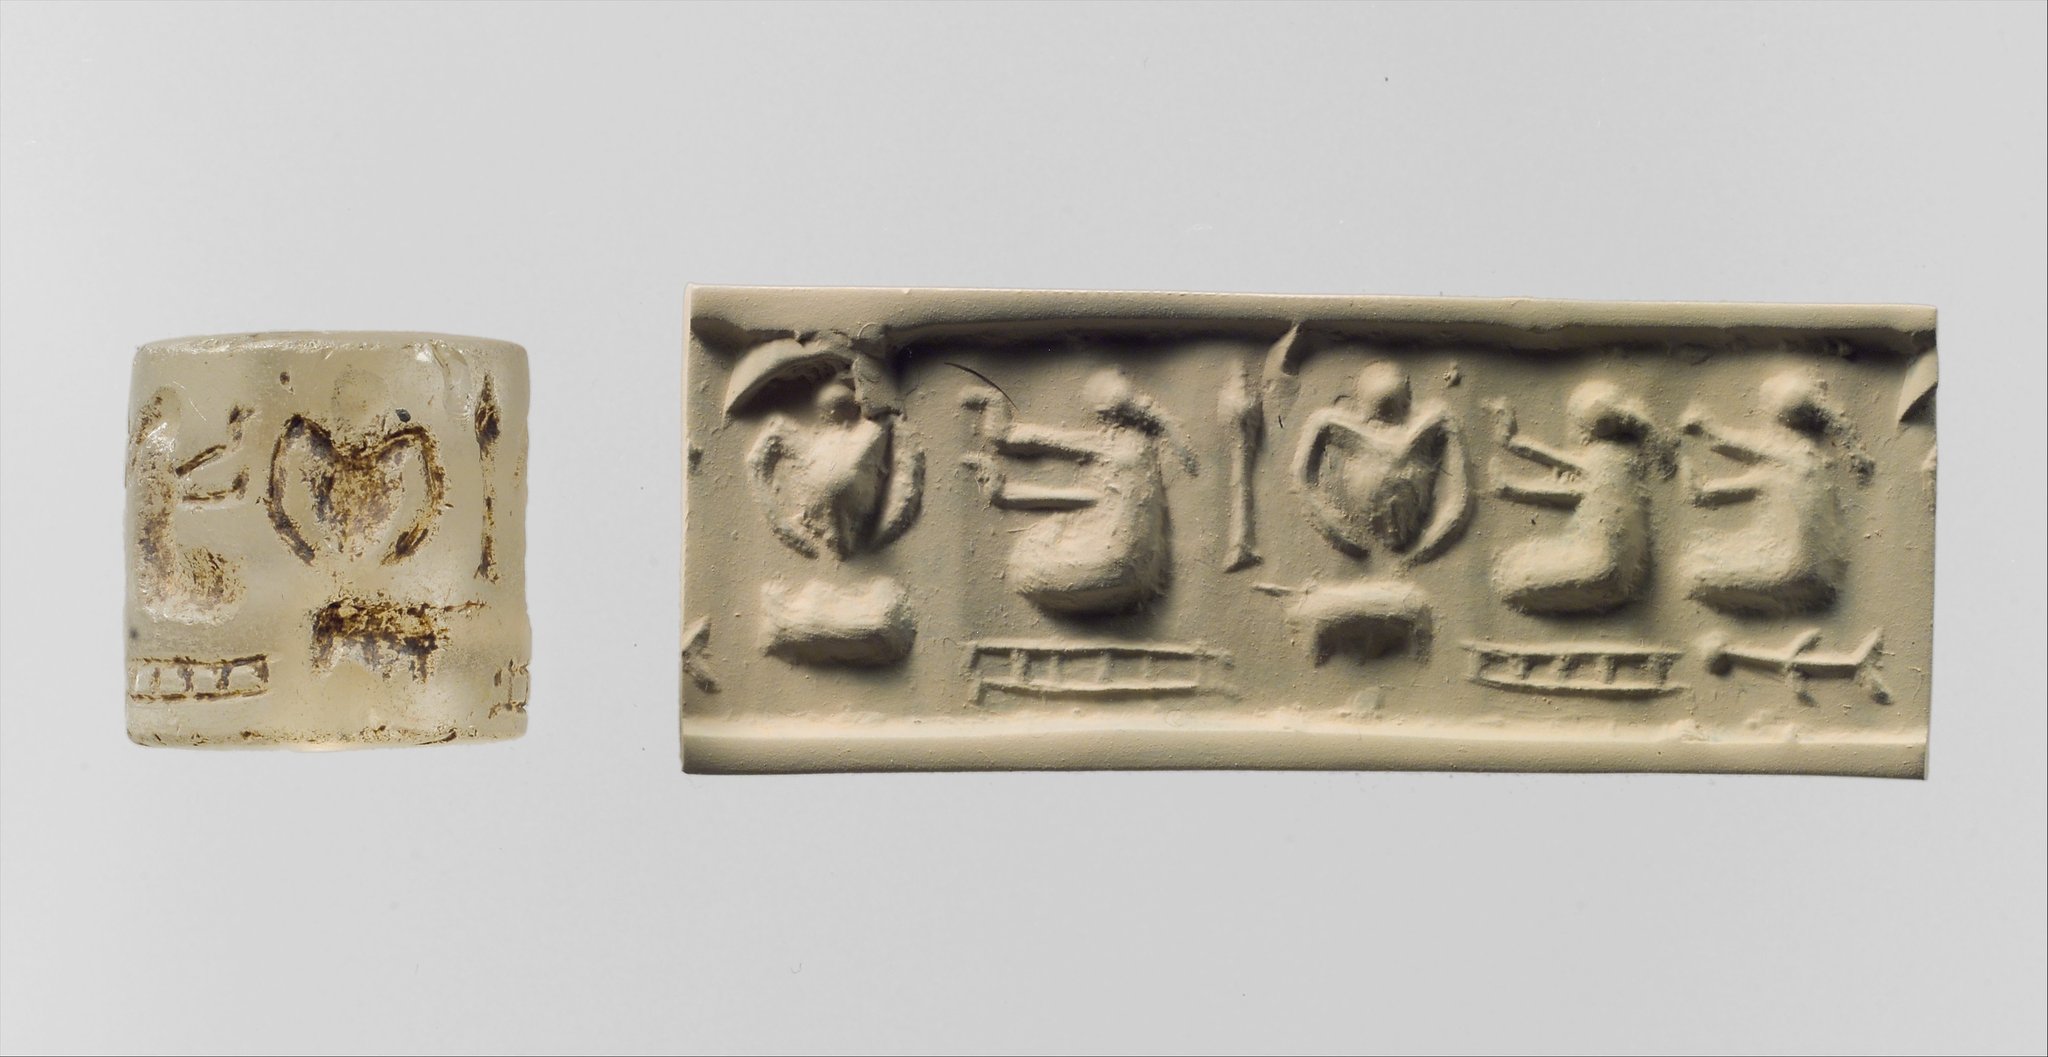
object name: cylinder seal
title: Cylinder seal and modern impression: three "pigtailed ladies" with double-handled vessels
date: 3300-2900 BCE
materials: quartz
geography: southern mesopotamia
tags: women